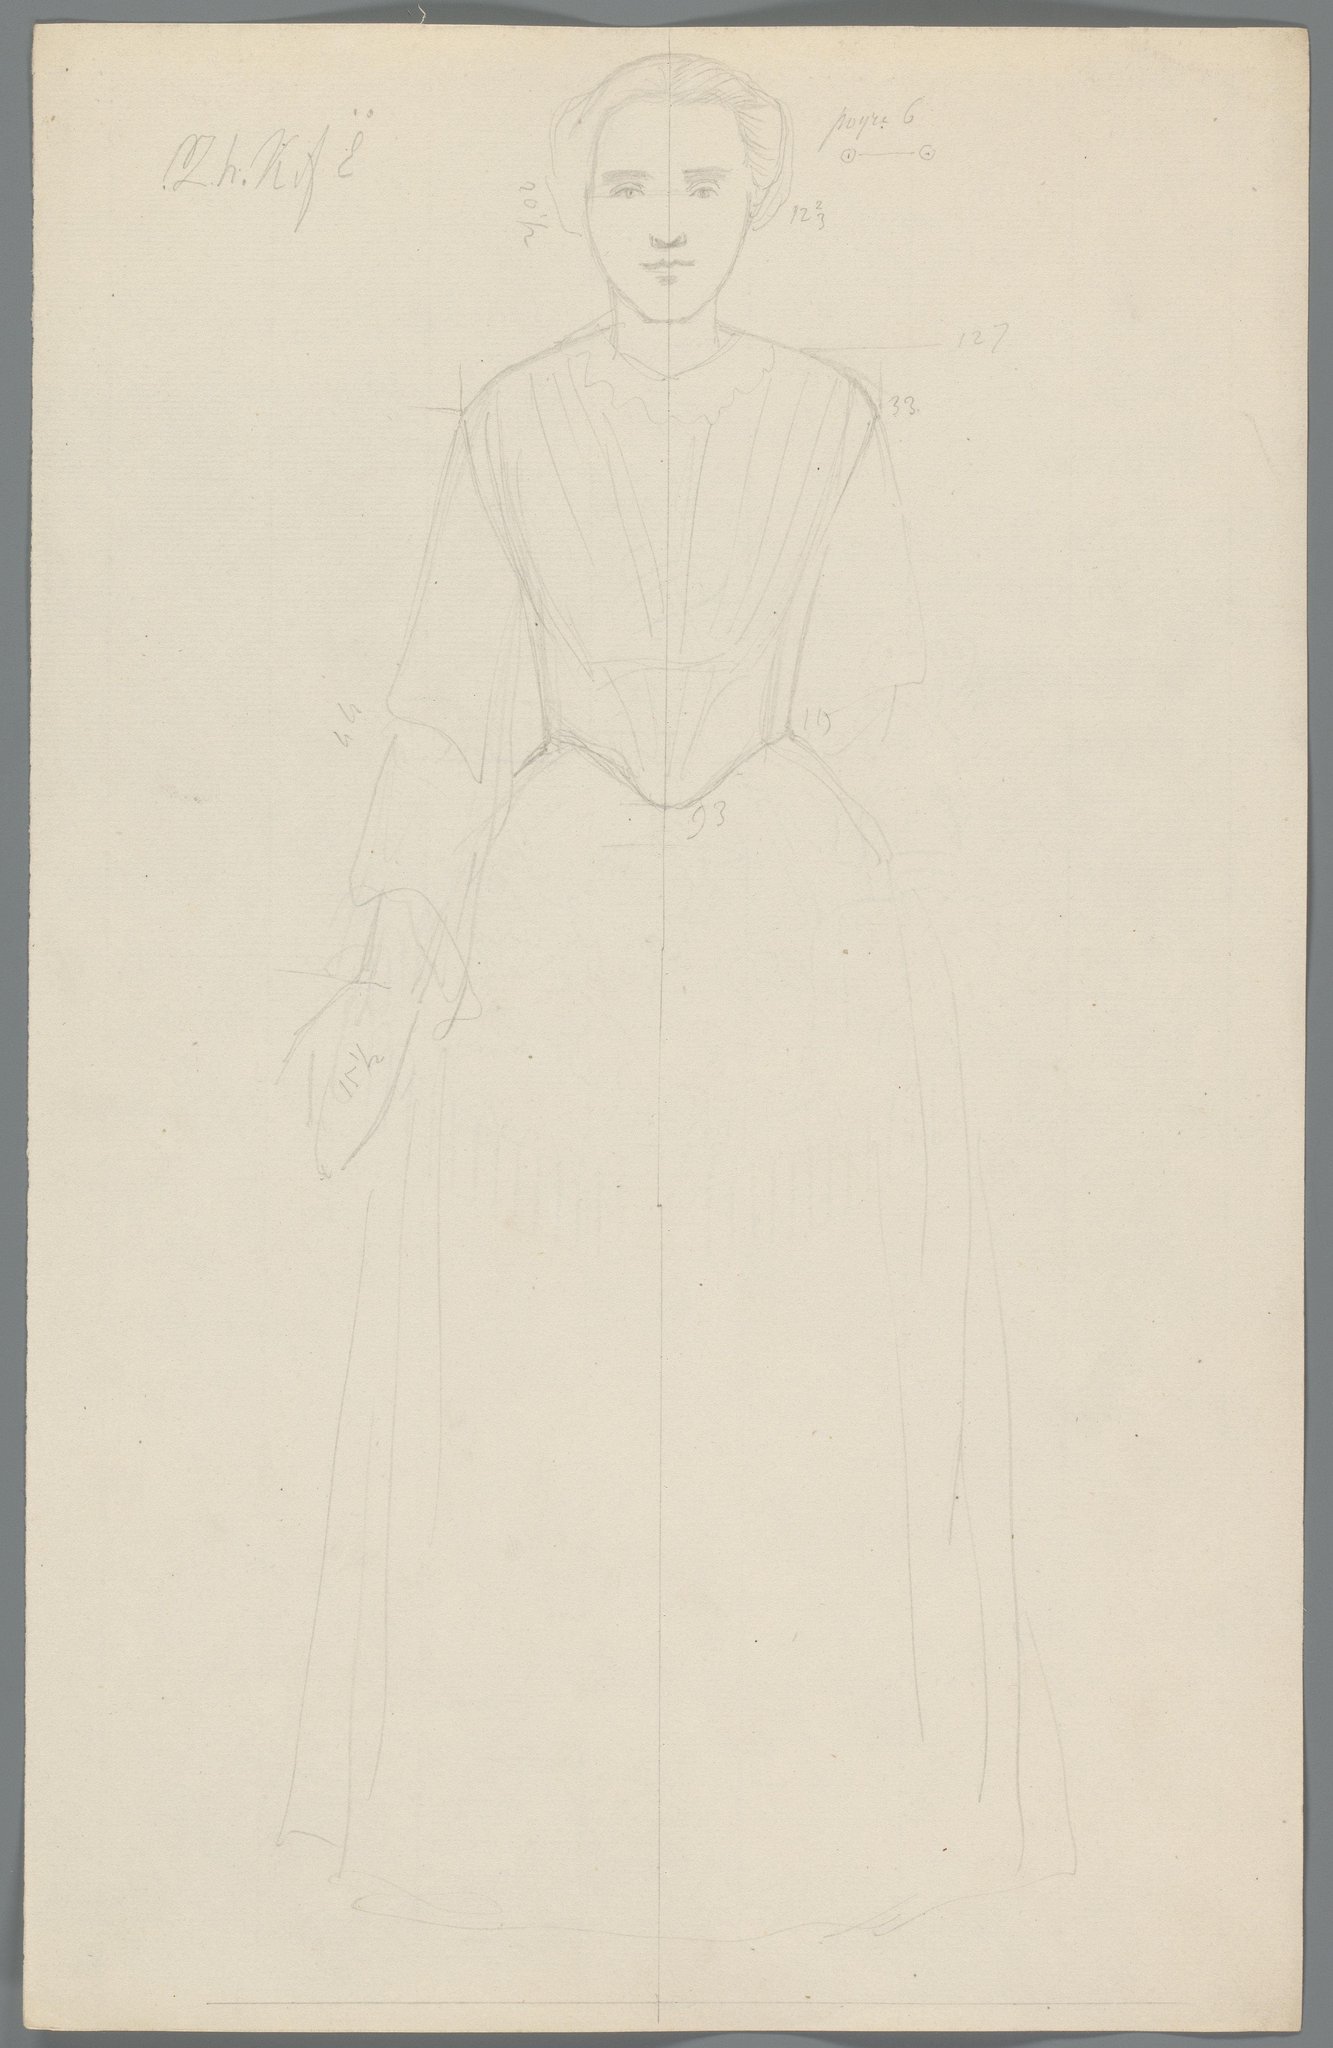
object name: drawing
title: Proportiestudie van een vrouw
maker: jacobus everhardus josephus van den berg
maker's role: draughtsman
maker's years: 1802-1861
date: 1812-1861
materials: paper, pencil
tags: standing figure (canon, proportions) - aa - female human figure